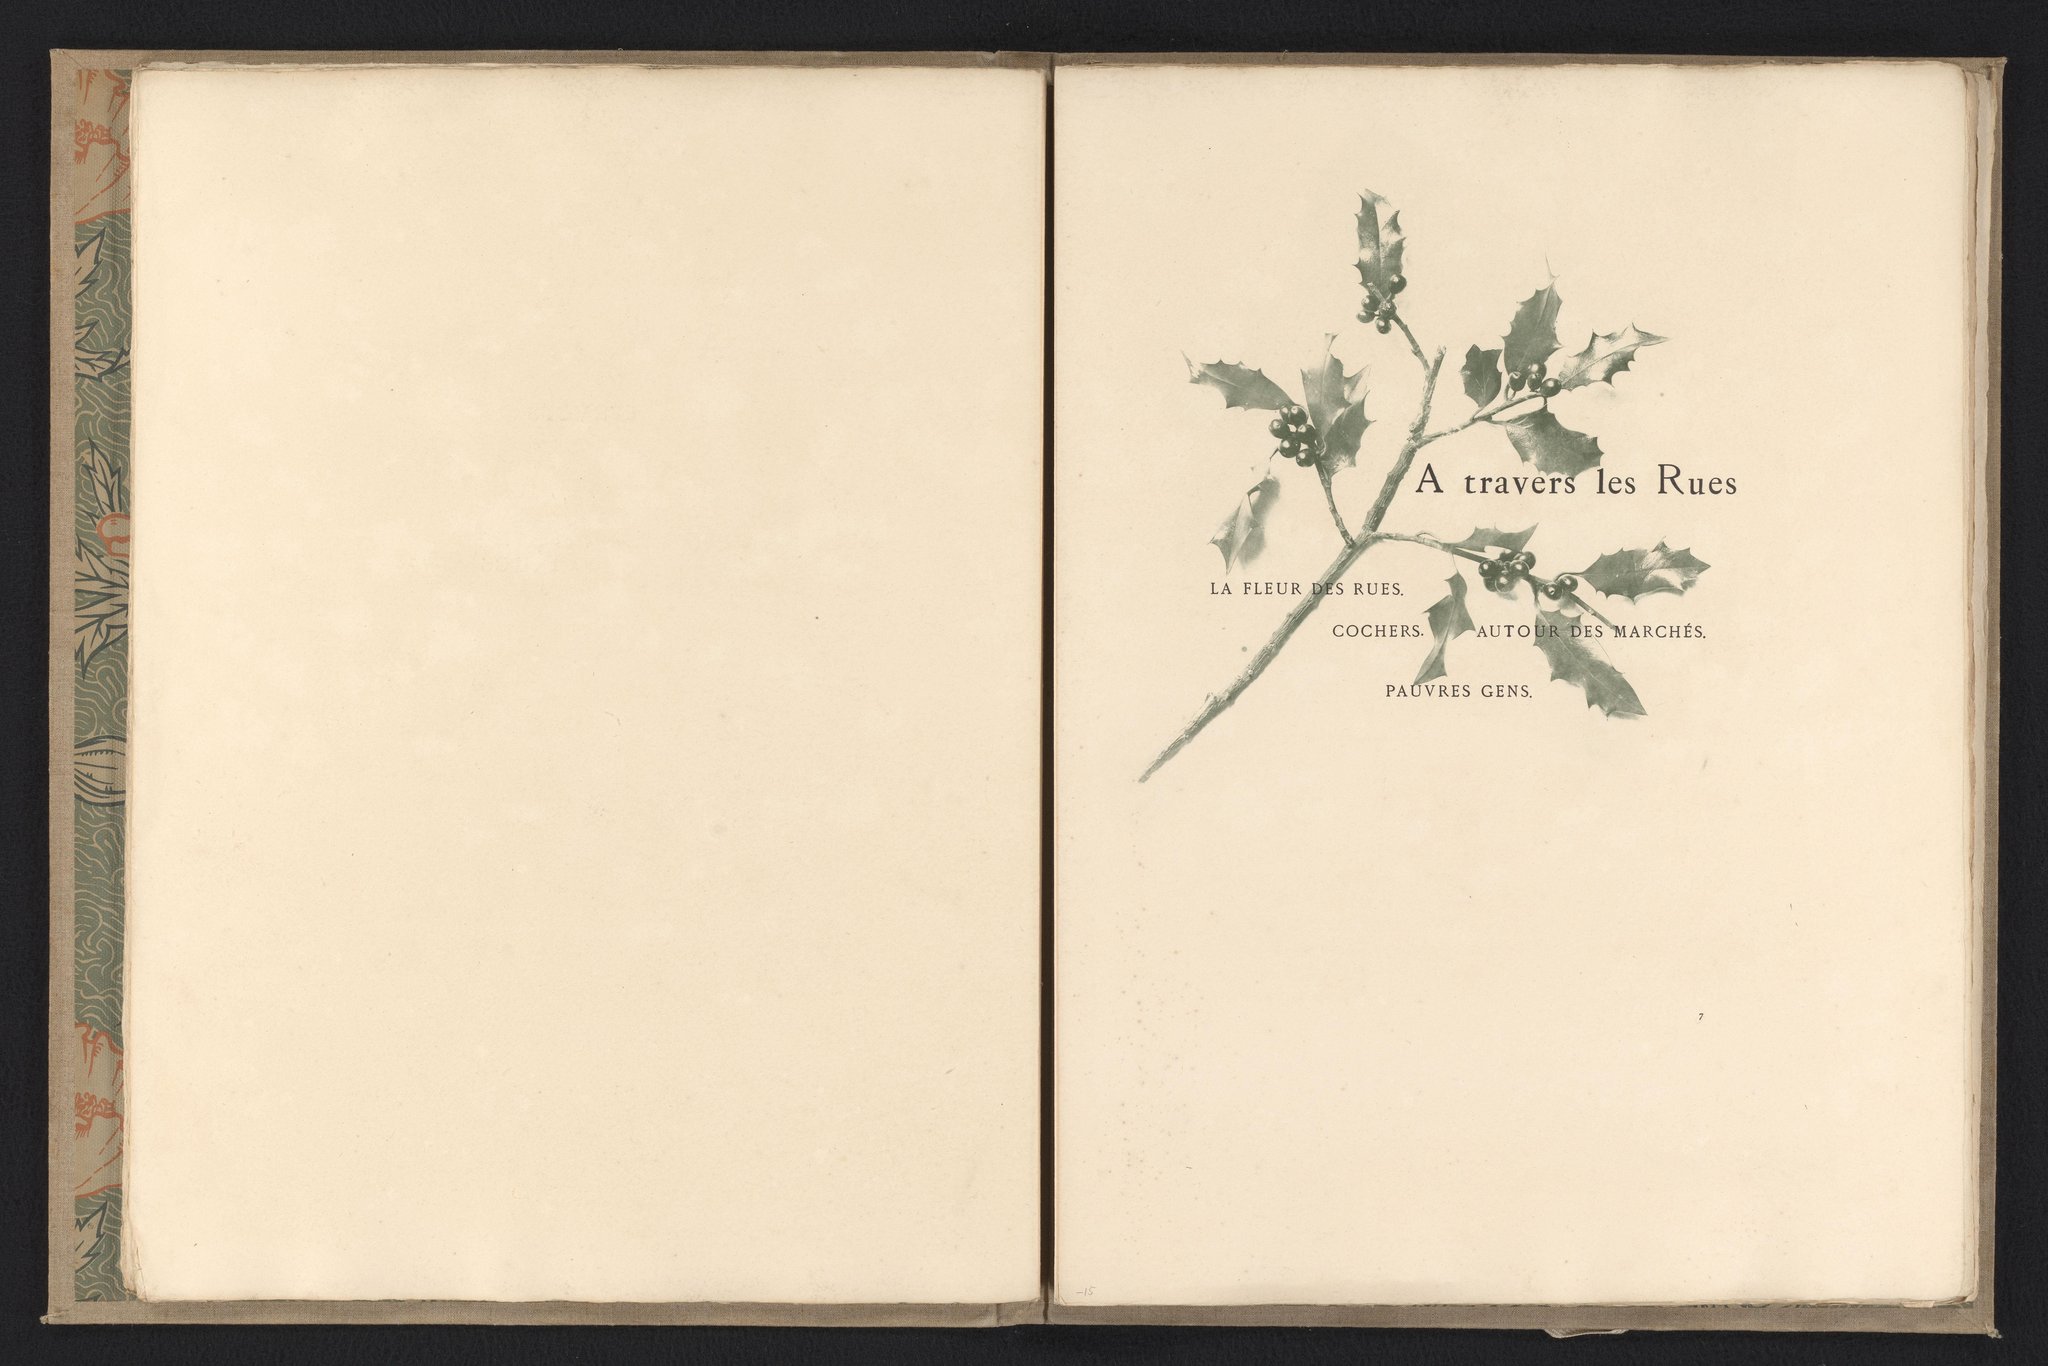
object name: photomechanical print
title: Hulsttak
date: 1896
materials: paper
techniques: photograph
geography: châteaudun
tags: shrubs: holly, paris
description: Prent op drieëntwintigste ongenummerde pagina.